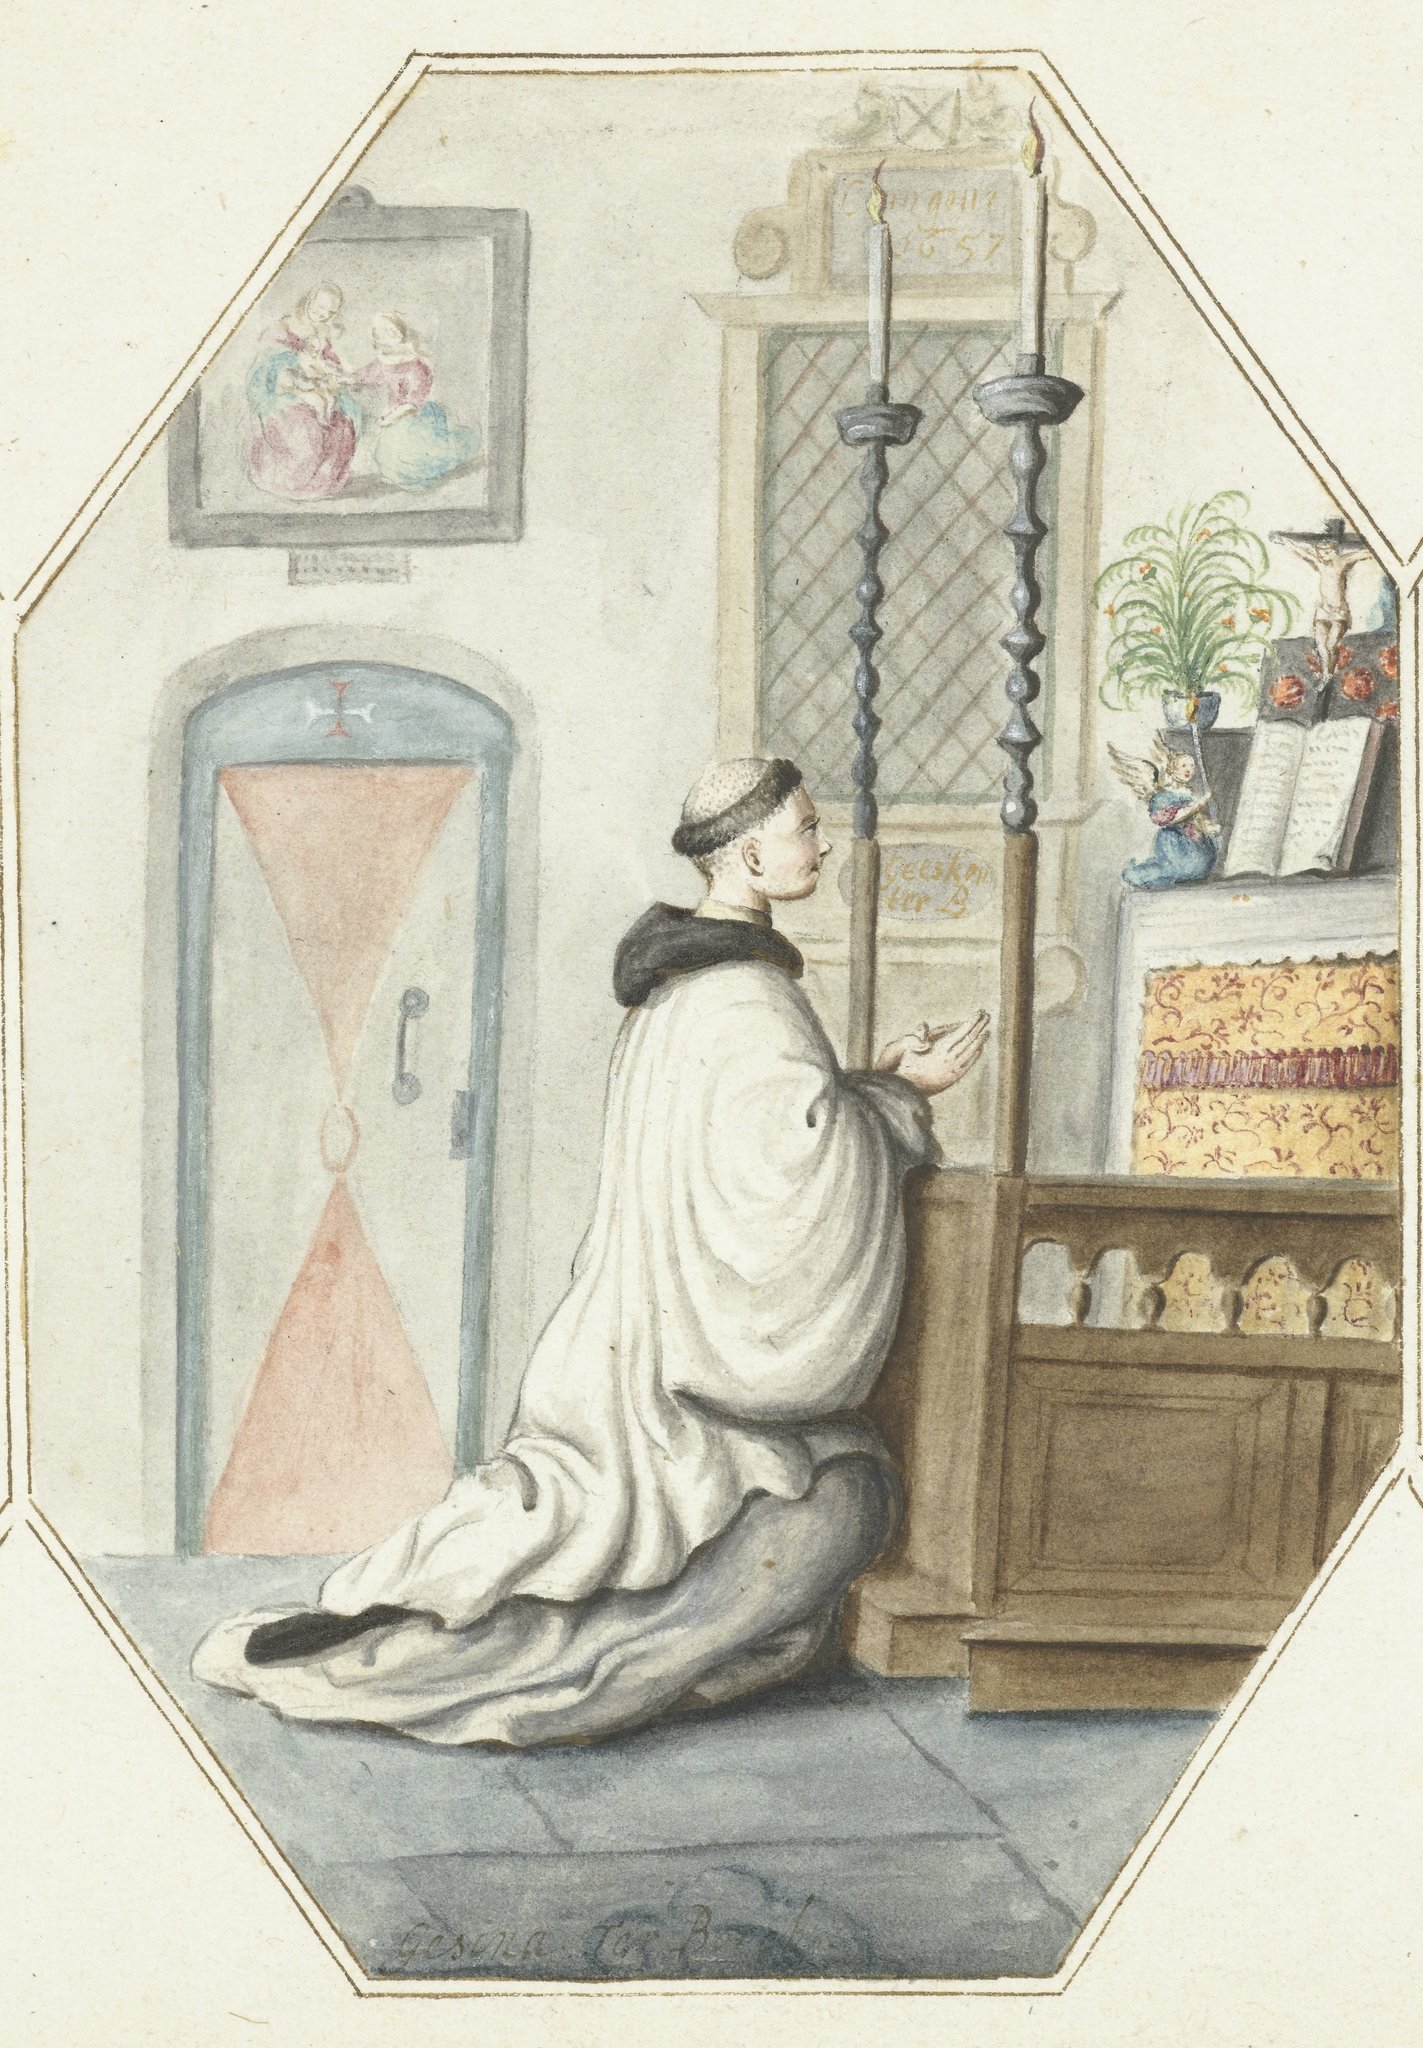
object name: watercolor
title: Knielende broeder bij een altaar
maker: gesina ter borch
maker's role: draughtsman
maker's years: 1633-1690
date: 1657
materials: paper, watercolor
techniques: brush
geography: zwolle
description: Broeder met een habijt van de Orde van de Kruisheren, in een achthoekig kader.